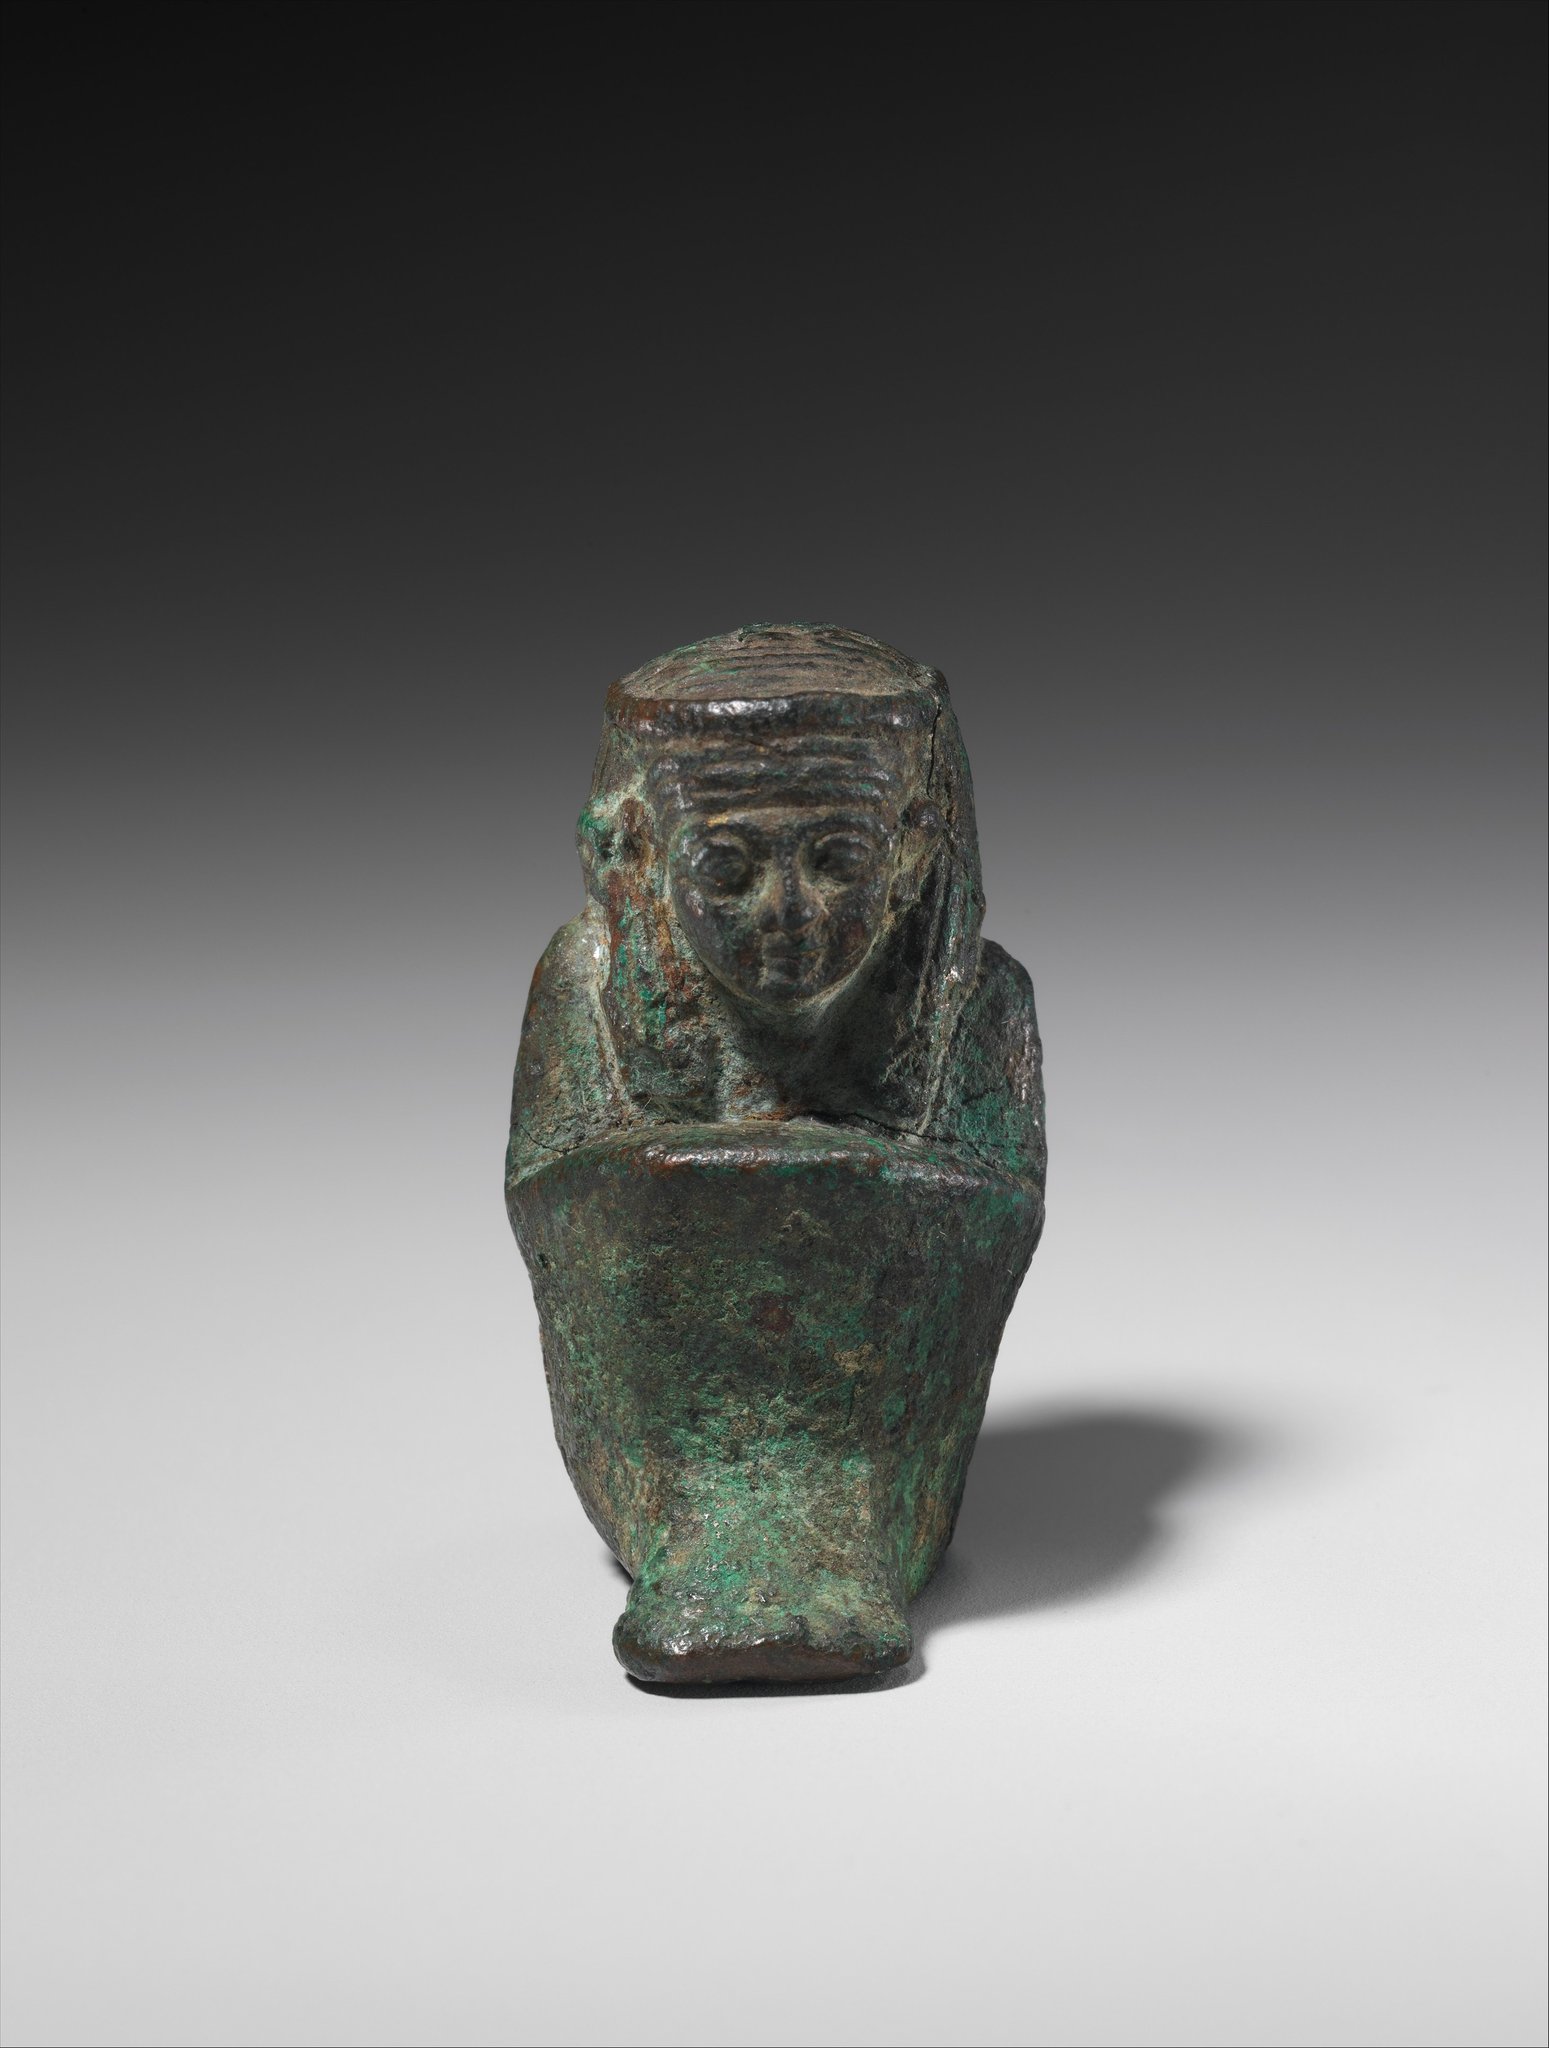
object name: maat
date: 1070-332 BCE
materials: copper alloy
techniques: gilding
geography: egypt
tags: goddess